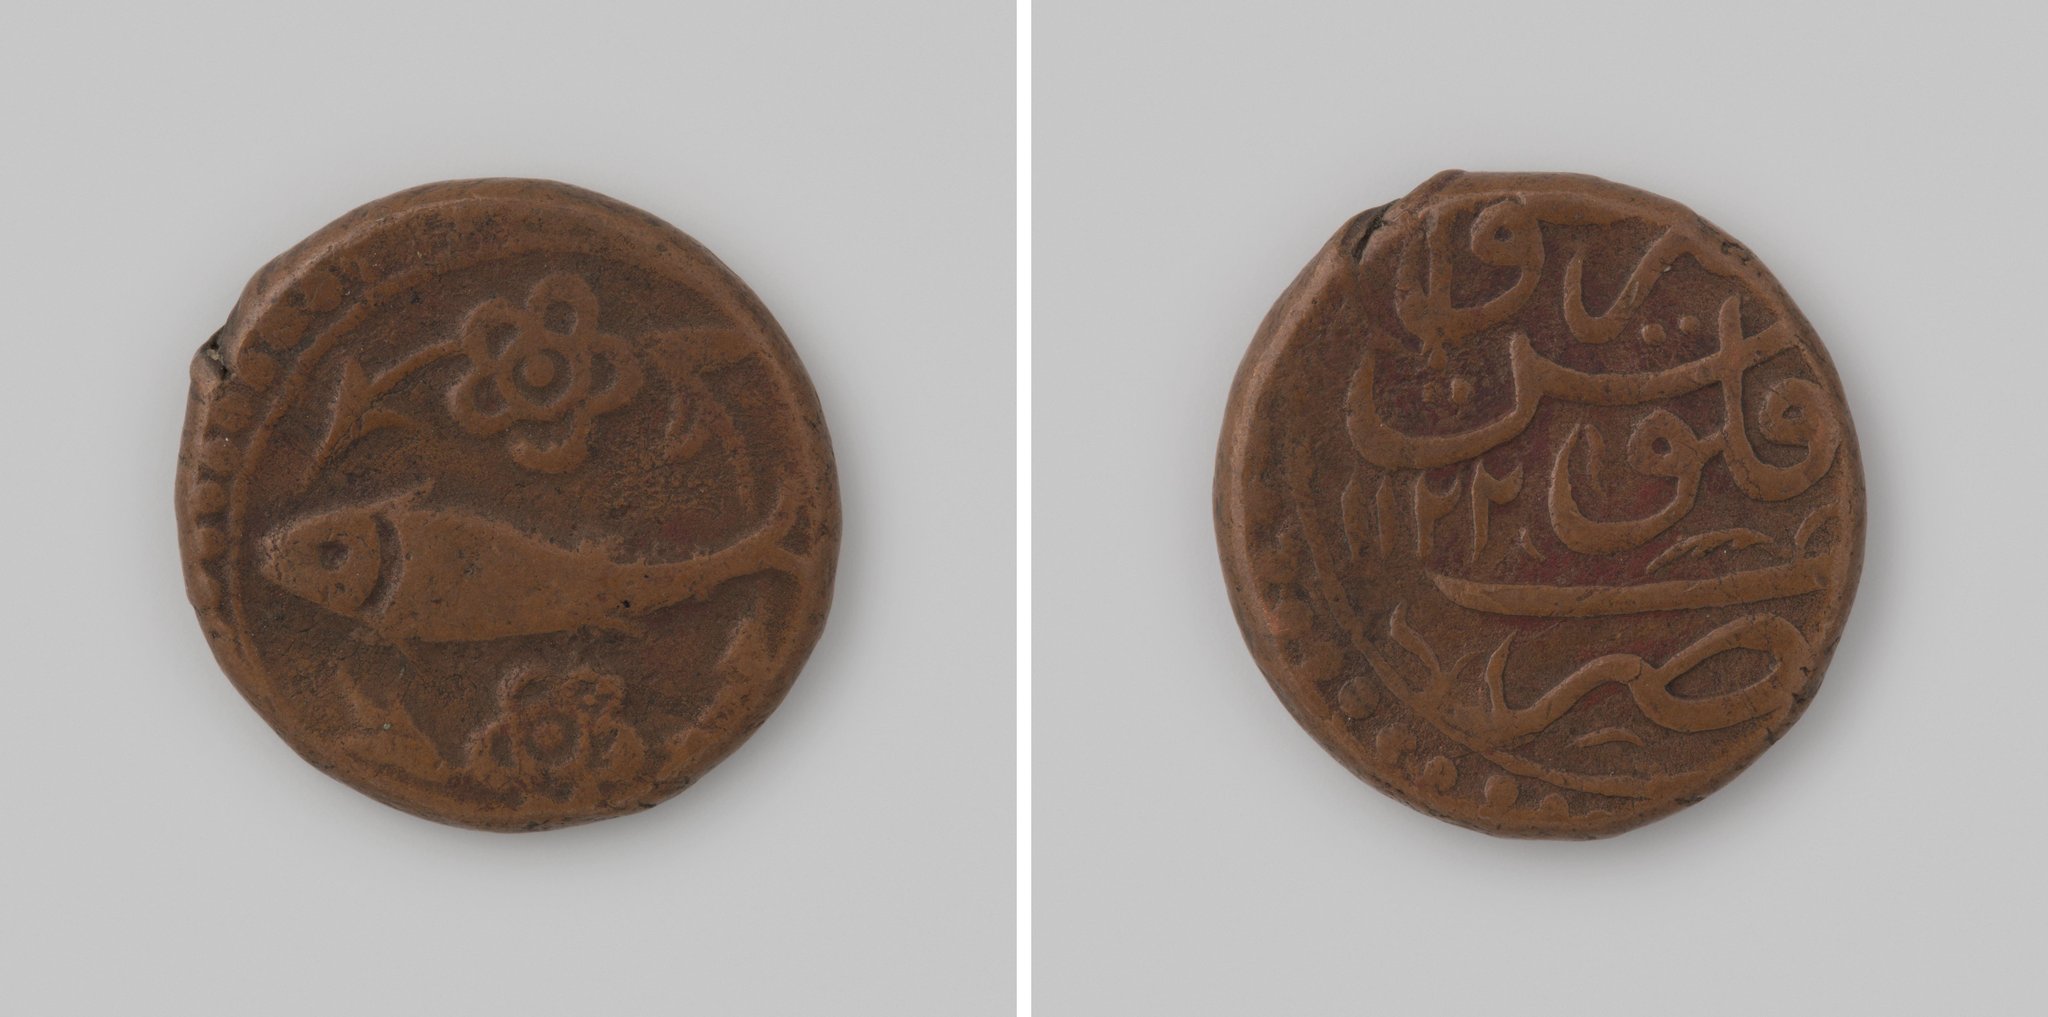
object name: coin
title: Perzië, ten tijde van sjah Hoesein, falus,1122 [=1709], Erivan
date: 1709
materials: copper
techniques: striking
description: Koperen munt. Voorzijde: vis naar links, waaromheen versiering. Keerzijde: in Arabische lettertekens in vier regels muntplaats-aanduiding, waartussen op derde regel jaartal-aanduiding. Geslagen te Erivan.